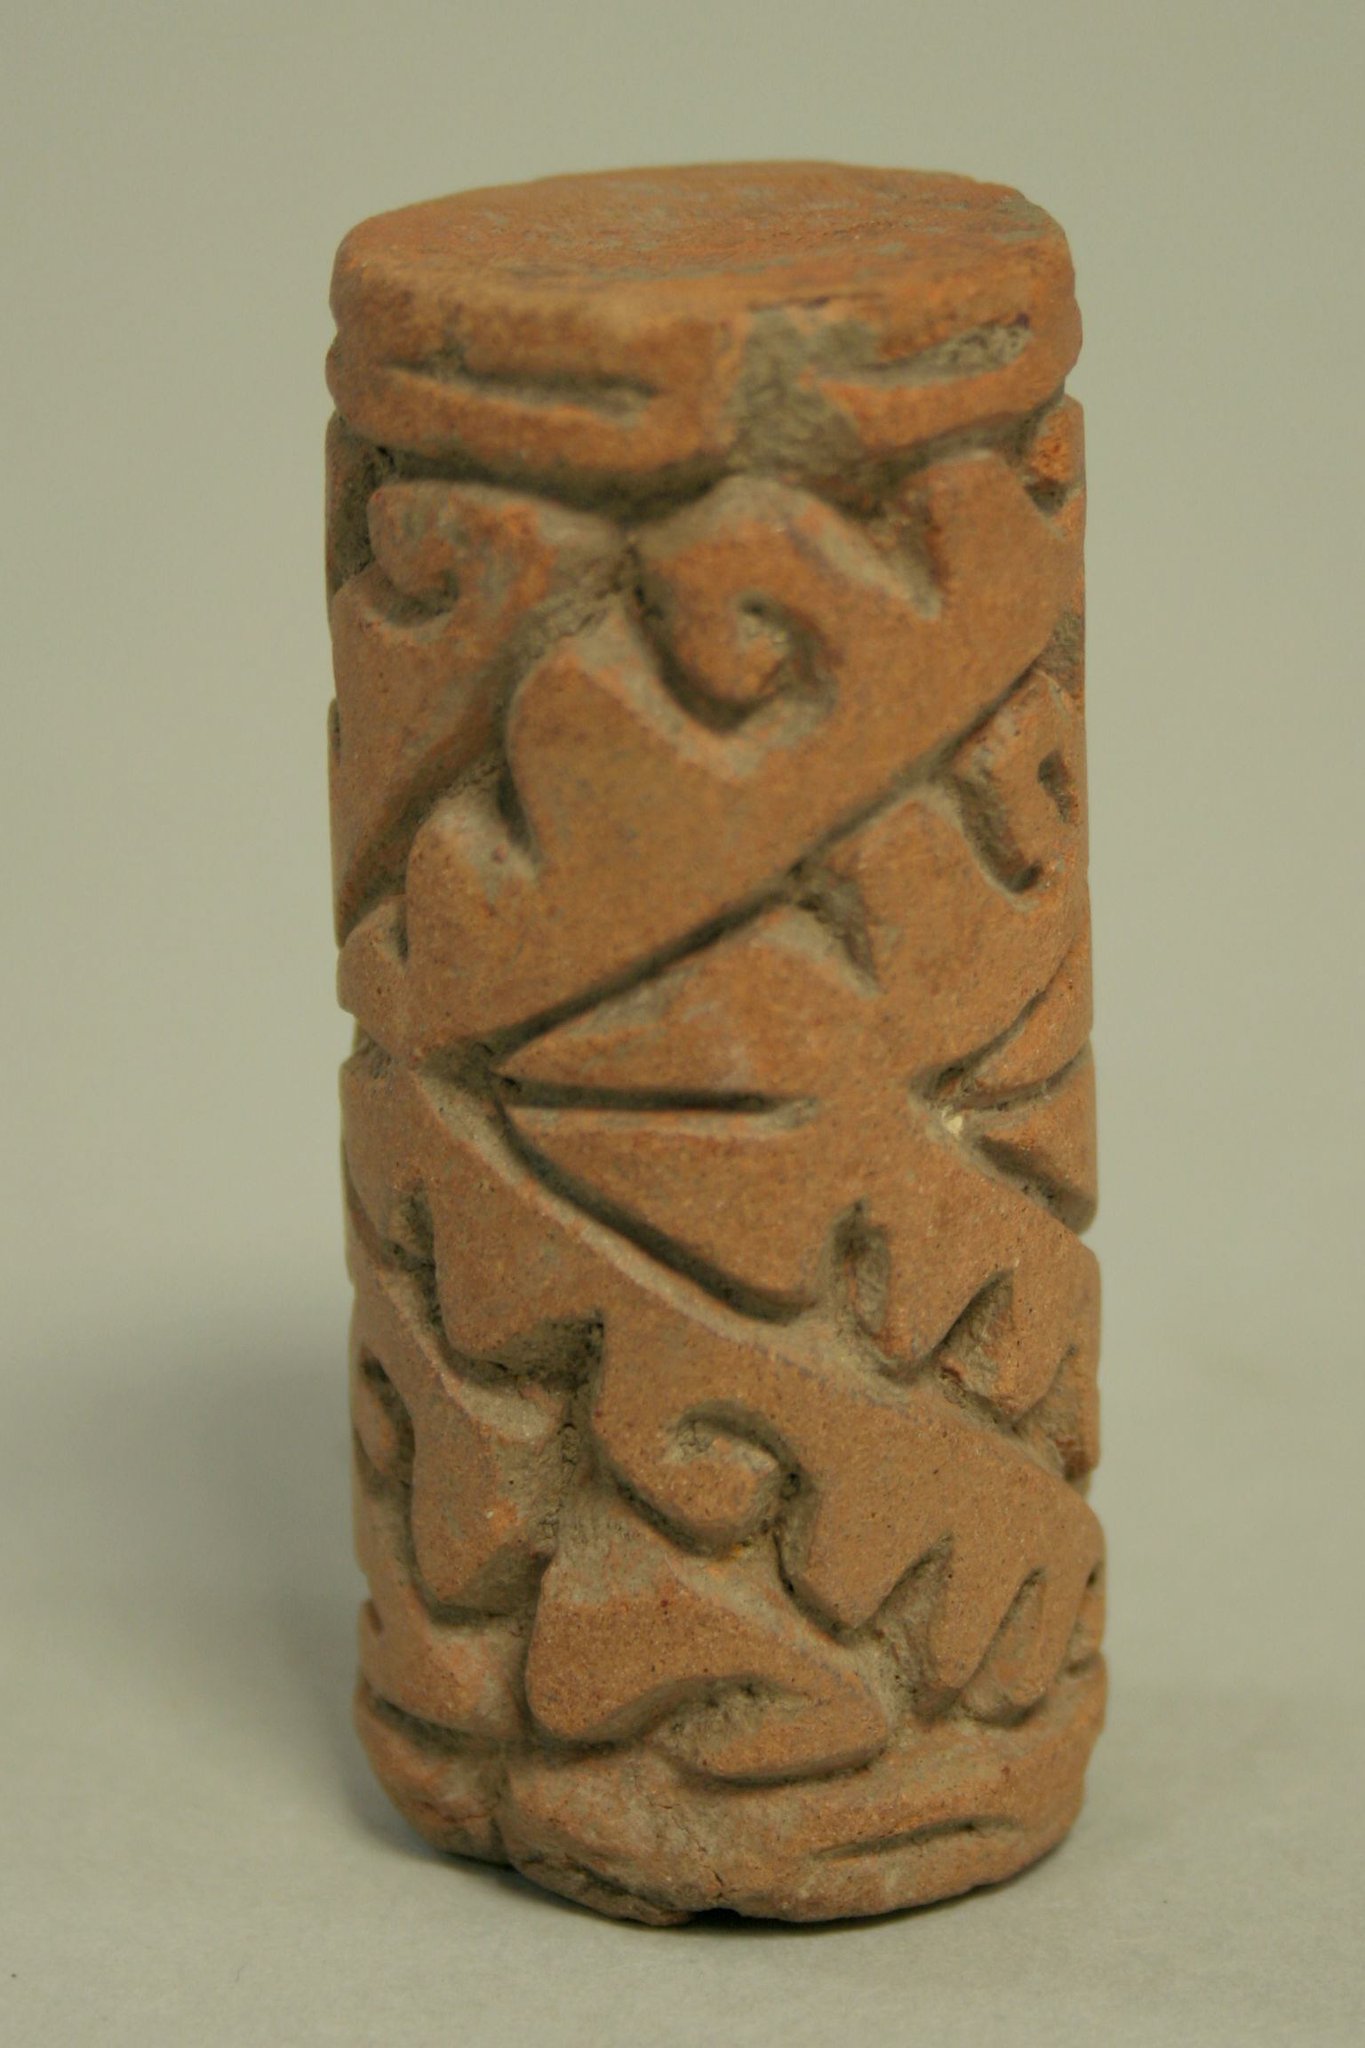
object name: stamp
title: Stamp Roller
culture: manteño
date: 801-1500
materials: ceramic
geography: ecuador